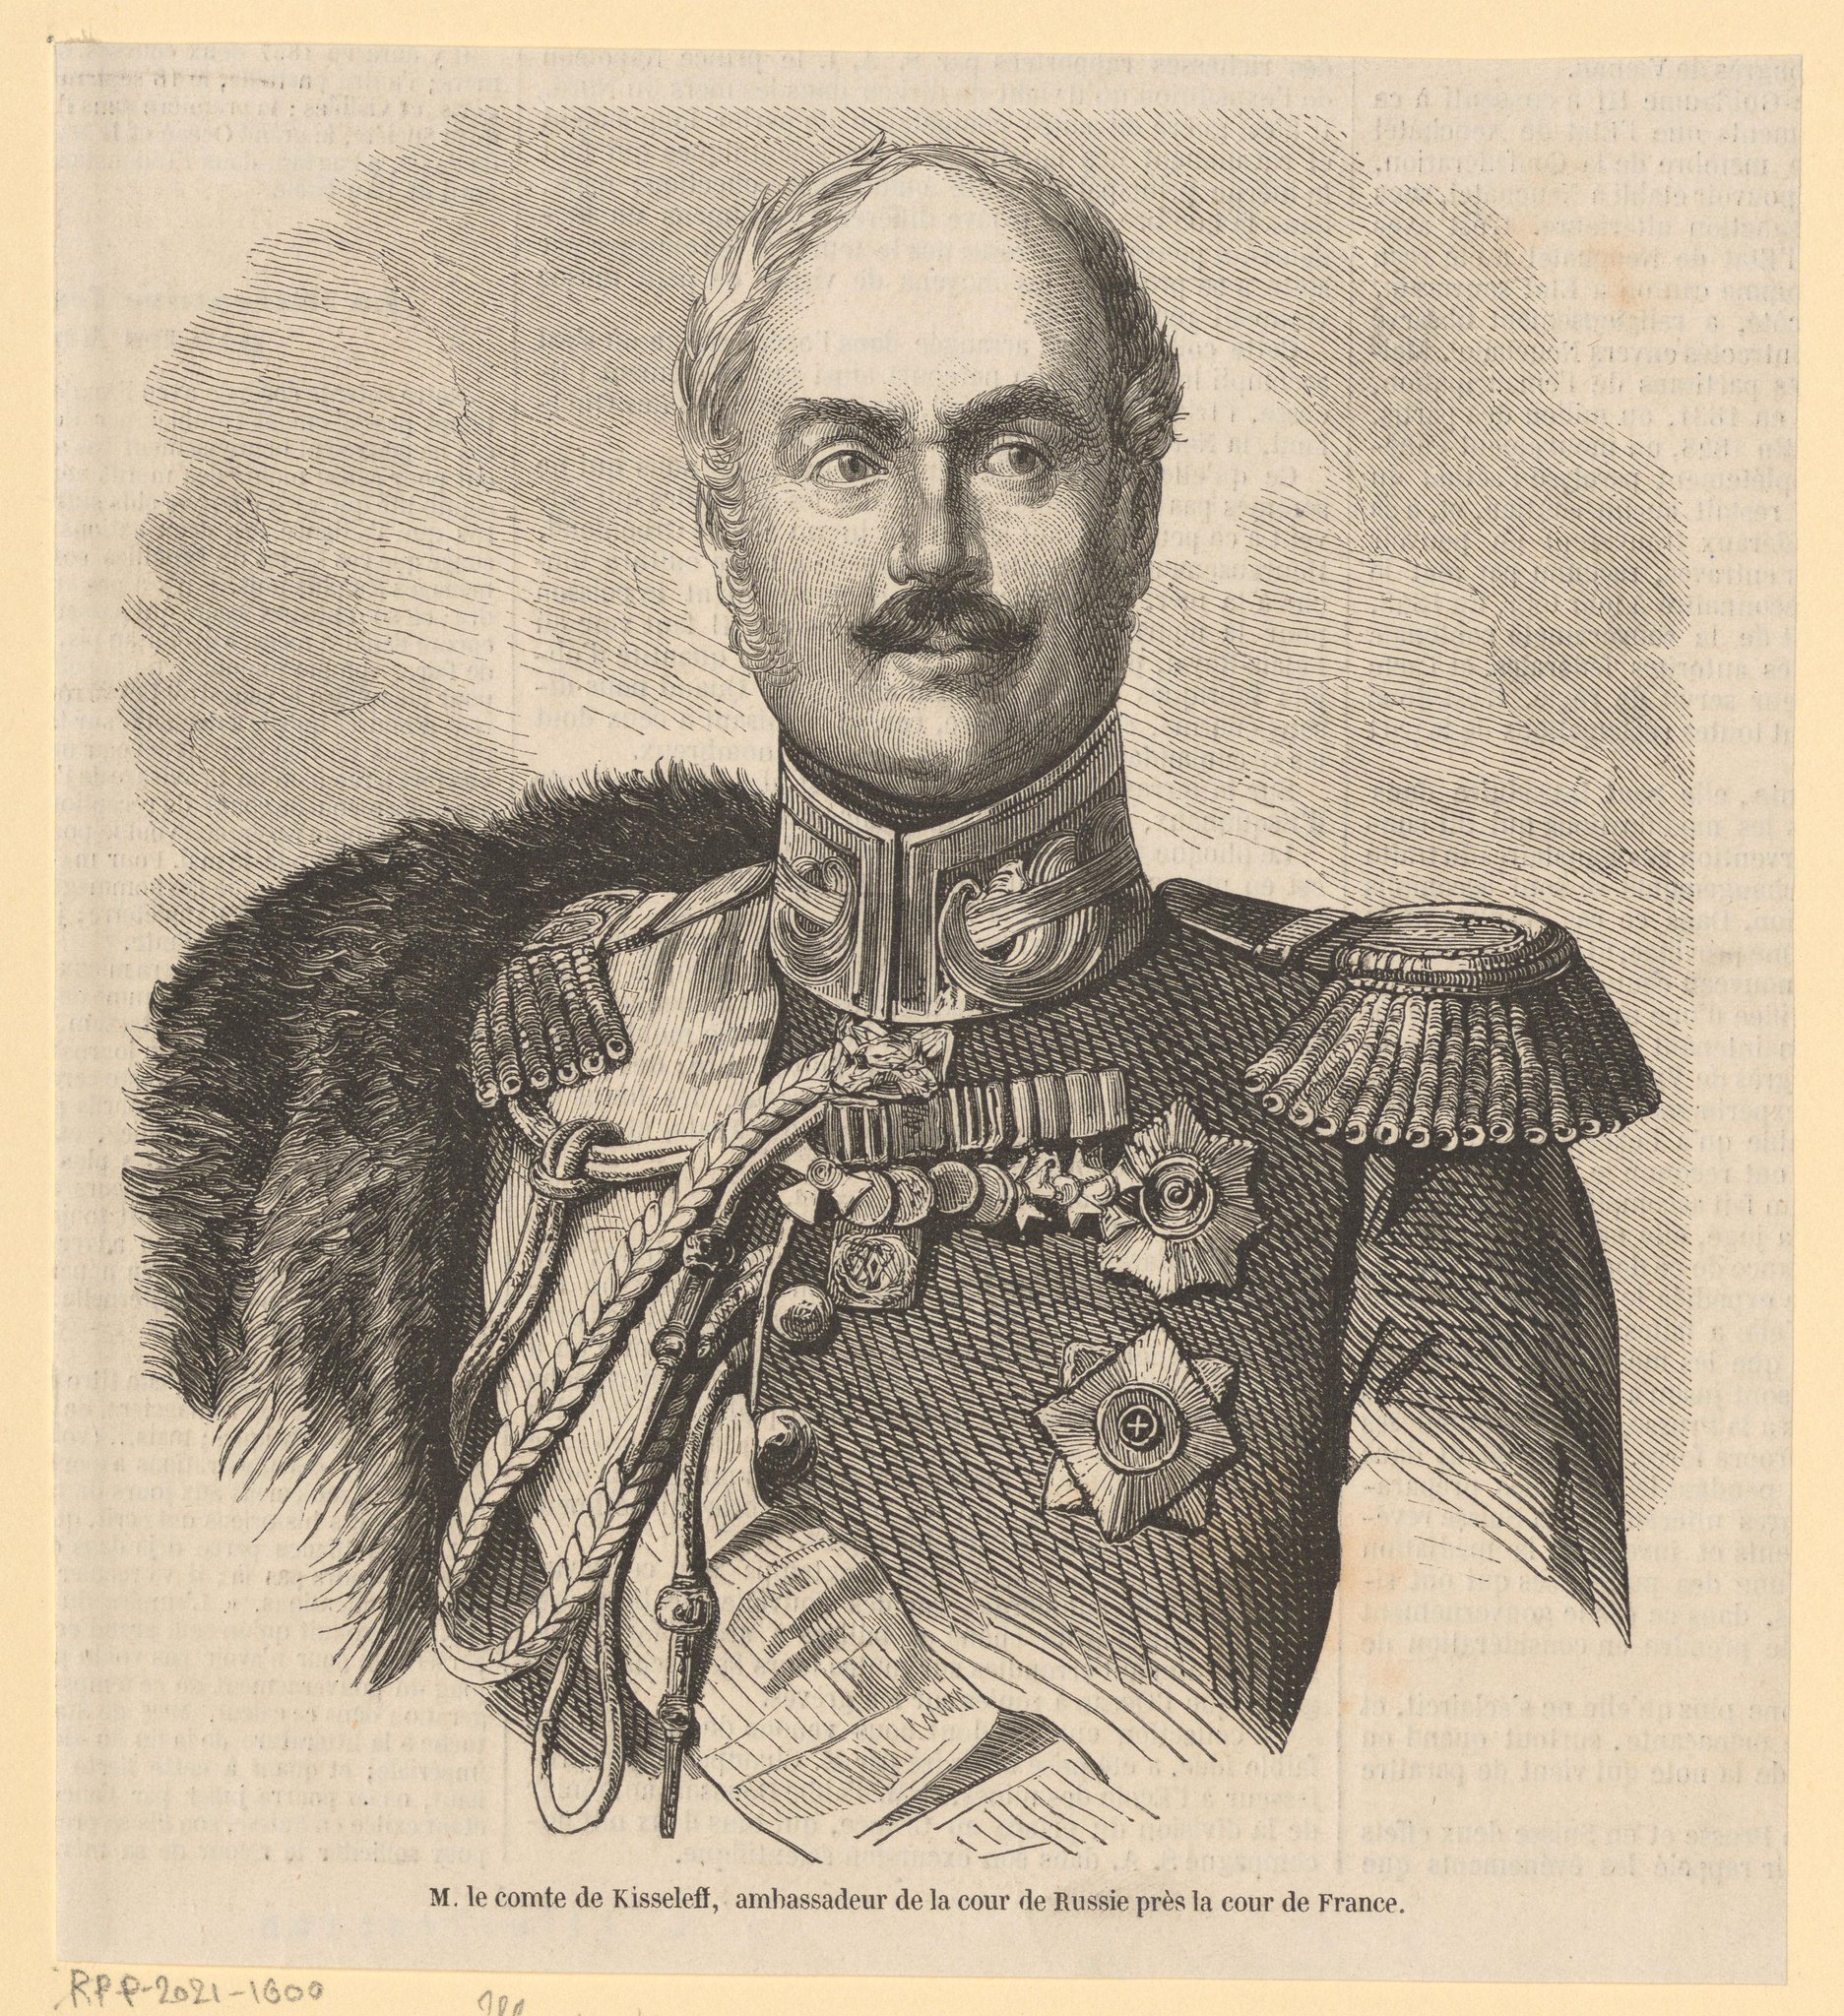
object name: print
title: Portret van Paul Kisseleff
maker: Anonymous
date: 1856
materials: paper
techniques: letterpress printing, engraving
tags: paris, historical persons, medals and other marks of military honour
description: Prent uit: L'Illustration, journal universel, nr. 721, 20 december 1856.